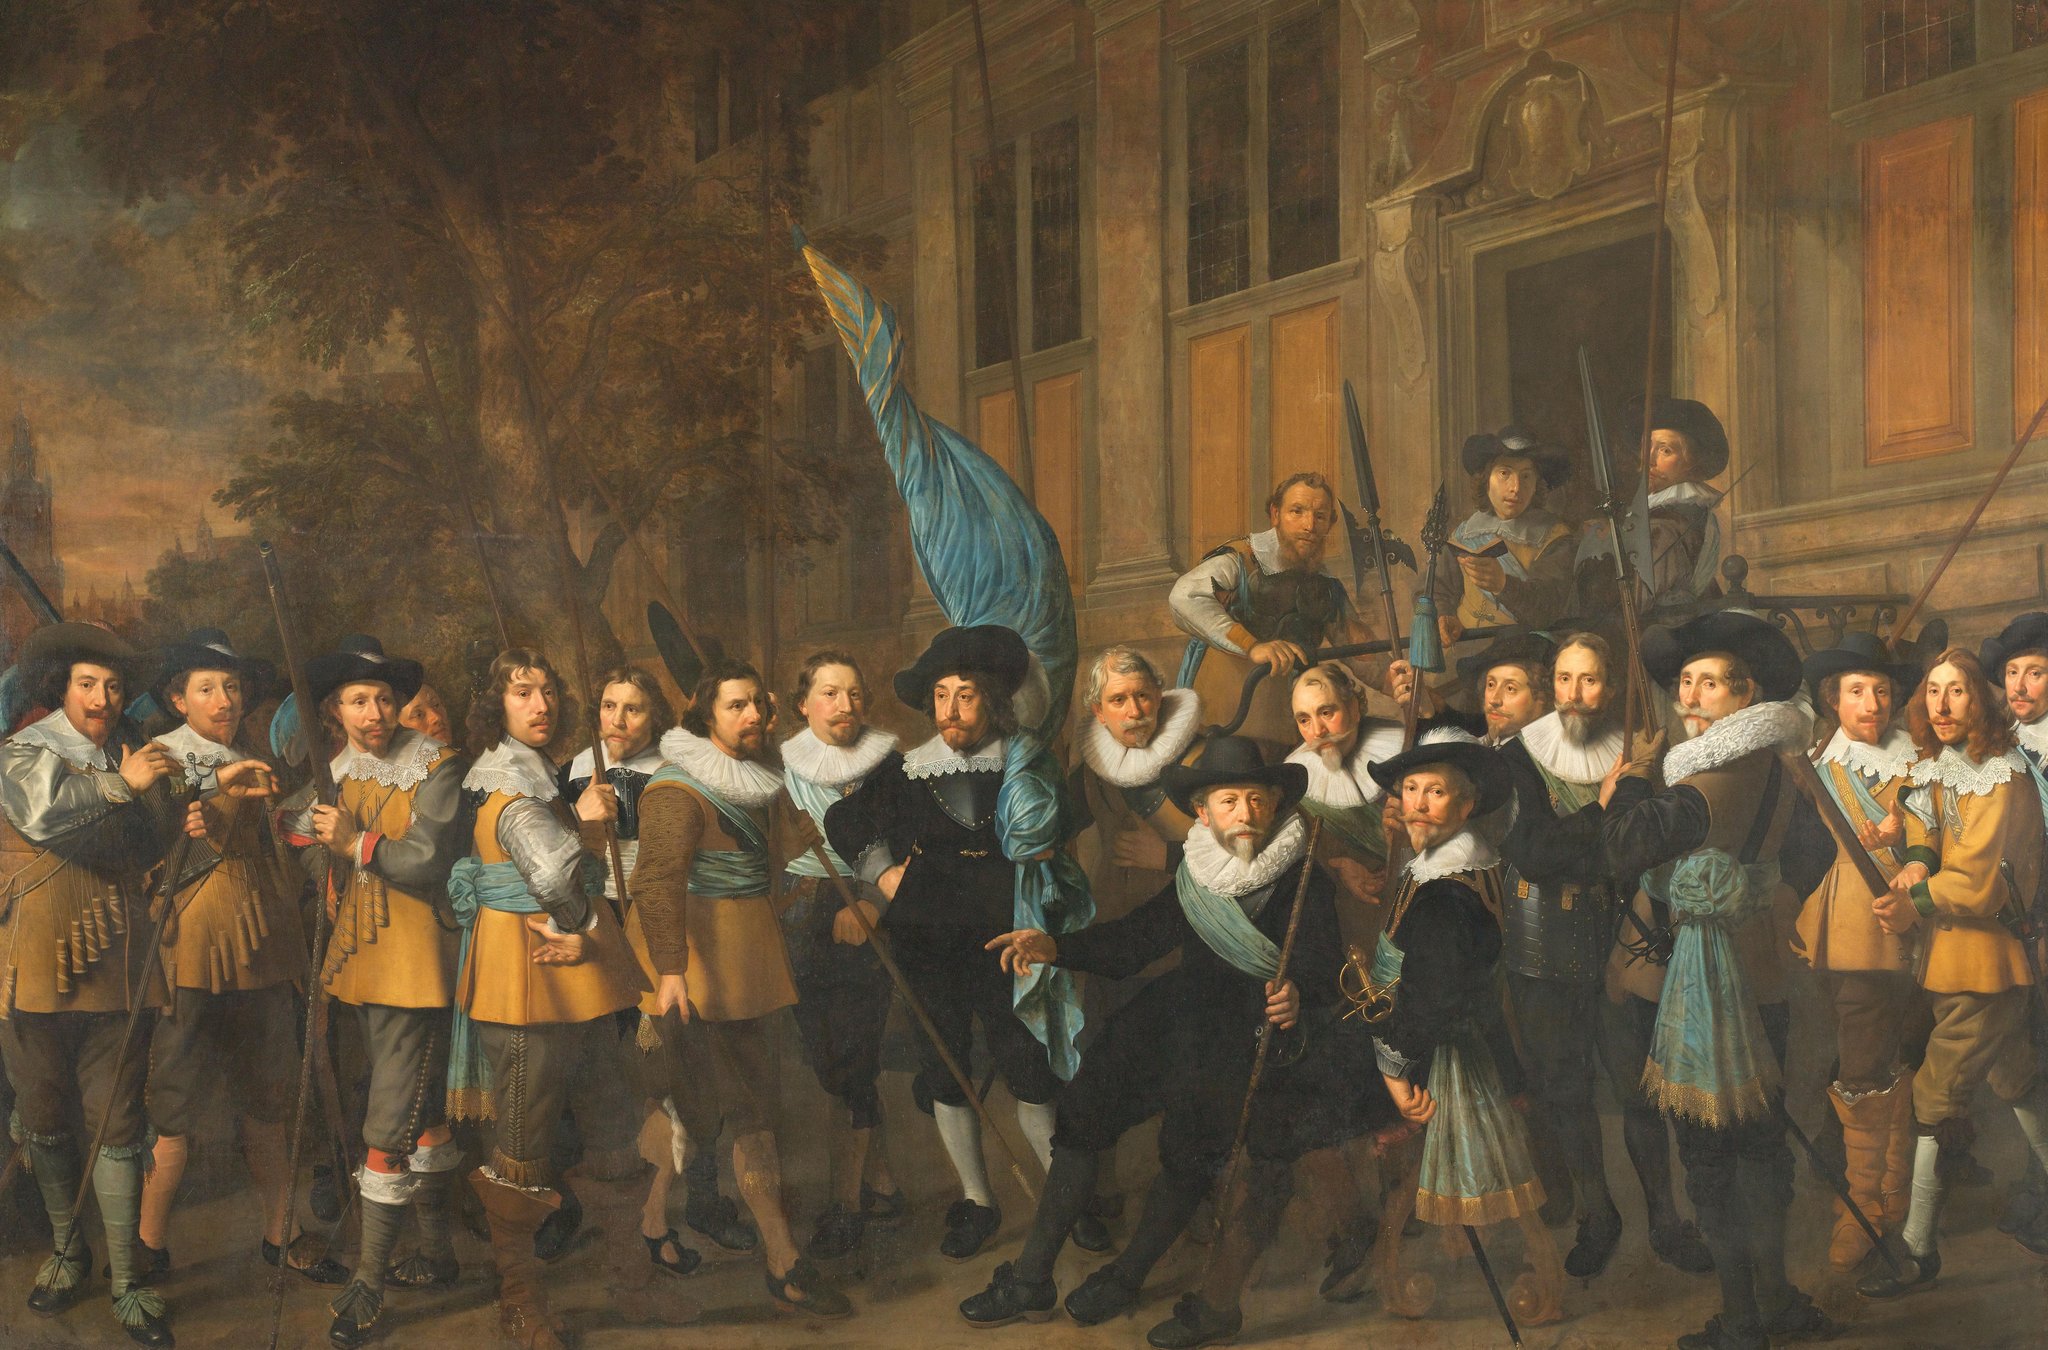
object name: painting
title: Officers and Other Civic Guardsmen of the IVth District of Amsterdam, under the Command of Captain Jan Claesz van Vlooswijck and Lieutenant Gerrit Hudde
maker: nicolaes eliasz pickenoy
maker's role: painter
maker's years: 1588-1656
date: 1642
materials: canvas, oil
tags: historical persons, land forces (+ citizen soldiery, civil guard, citizen militia), amsterdam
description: Schuttersstuk van het korporaalschap van kapitein Jan Claesz Vlooswijck en luitenant Gerrit Hudde, van de Kloveniersdoelen te Amsterdam, 1642. De kapitein en de luitenant zijn gezeten, om hen heen staan de schutters, in het midden de vaandrig. Vermoedelijk bevinden zij zich voor de brouwerij 'De Zwaan'. De schutters zijn: Jan Witsen, Hillebrant Bentes, Andries Dircksen van Saane, Jan Bentes, Willem Simonsz Moons, Jan Huybertsen Codde, Roelof Roelofsen de Lange, IJsbrant van de Wouwer, Johannes Looten, Ulrich Petersen, Jacob Bleyenberch, Pieter Harpertsen, Pieter Tonneman, Evert Huibertsen Krieck, Hendrik Jansen van As en Nicolaes Kuysten. De schutters zijn bewapend met pieken, hellebaarden, lansen en geweren.